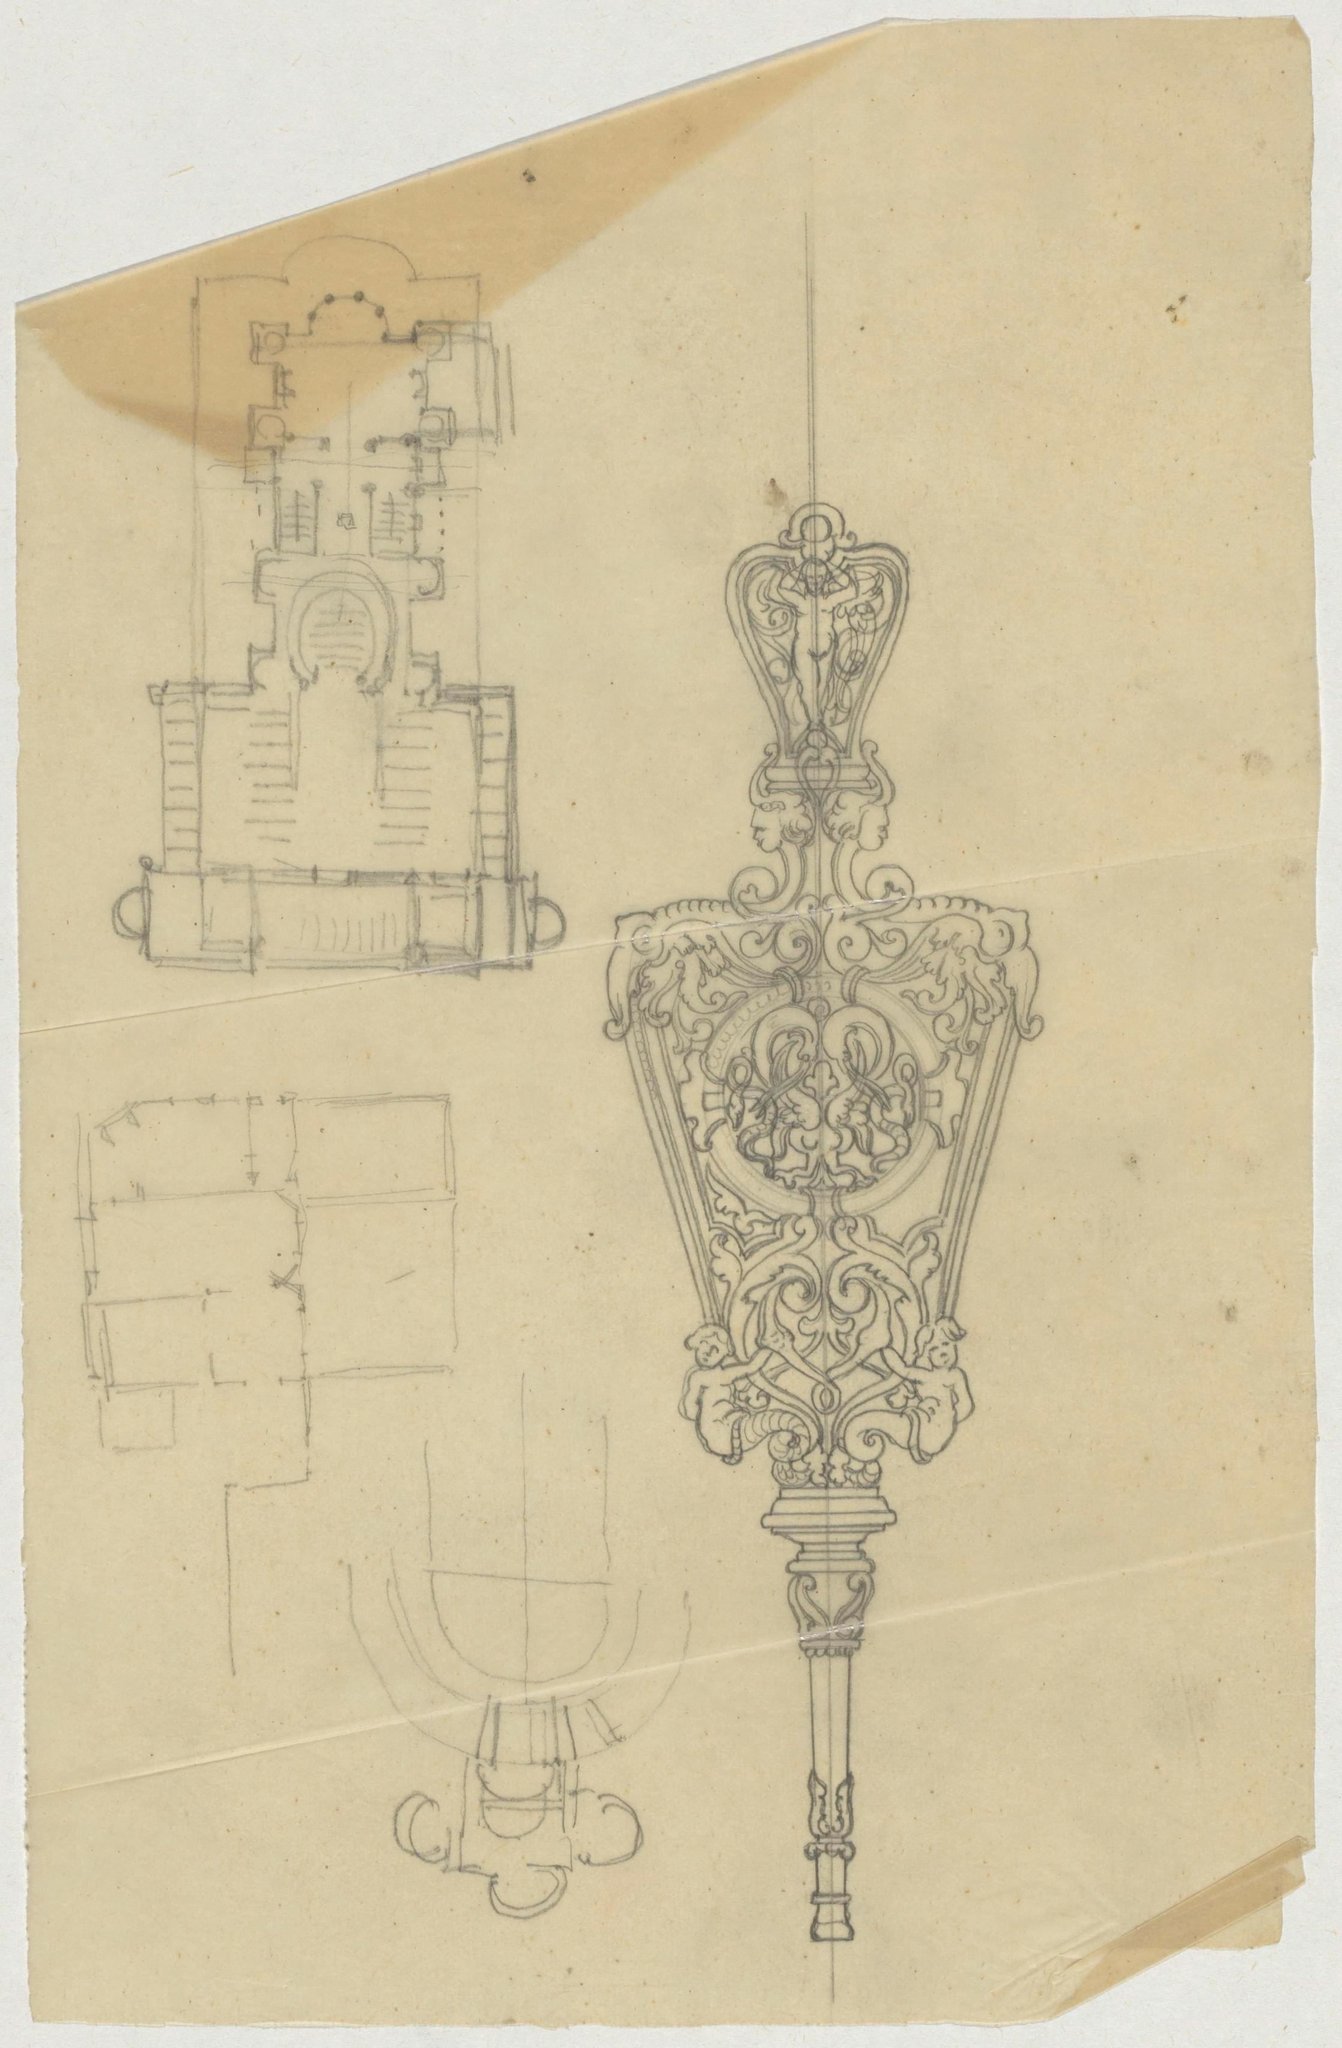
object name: design drawing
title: Blaasbalg en architectonische plattegrond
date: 1830-1850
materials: graphite, paper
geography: paris